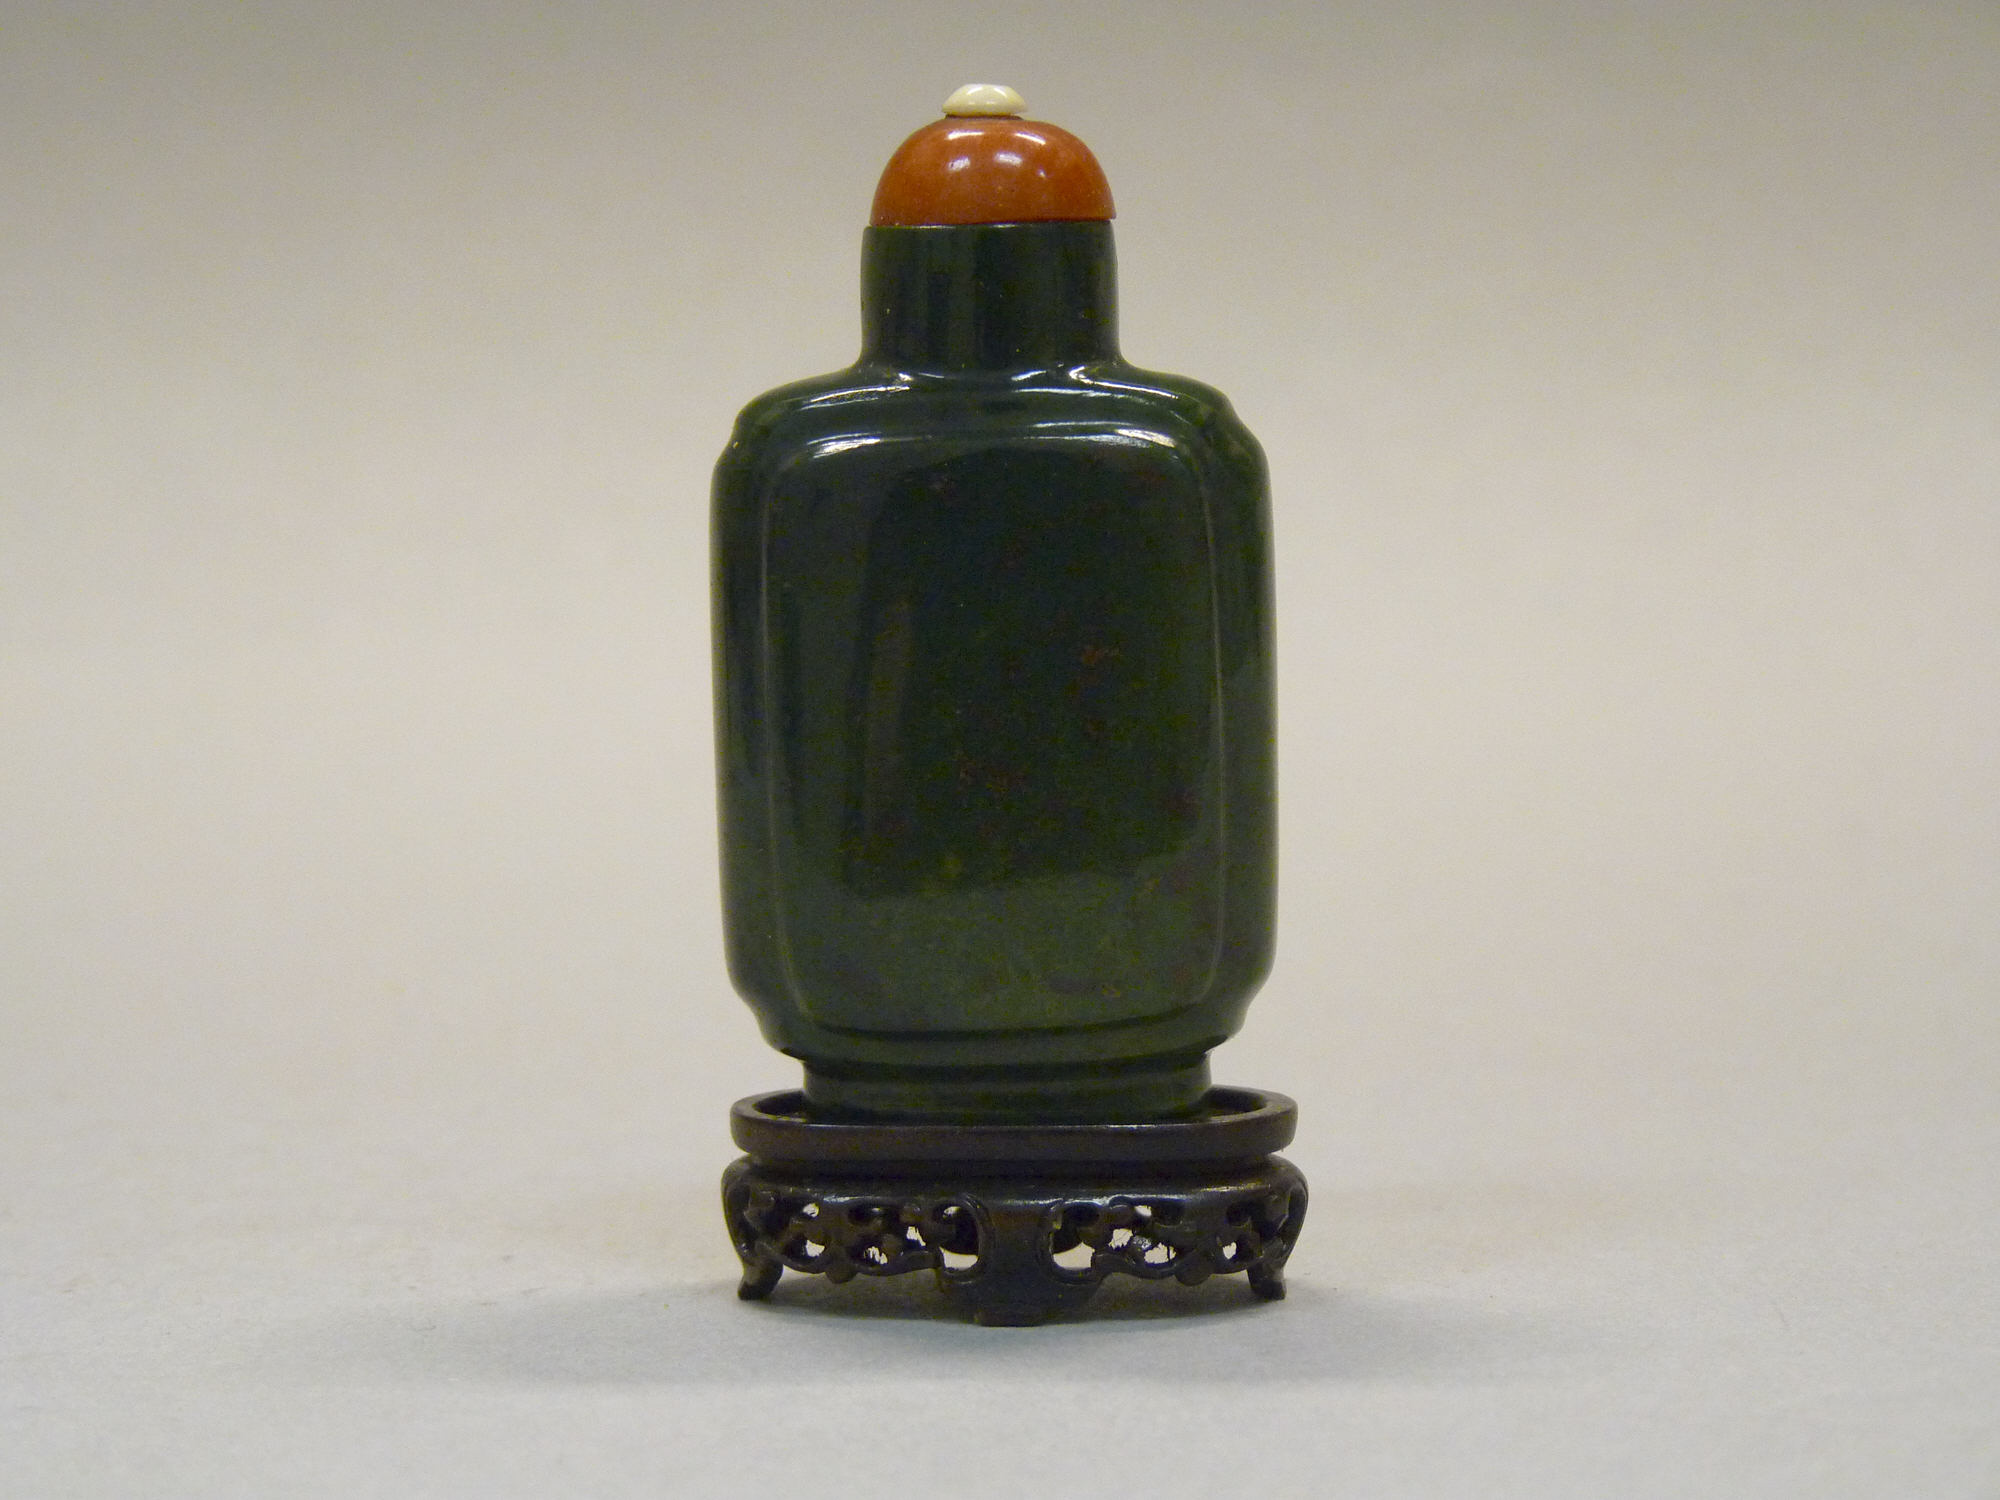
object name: snuff bottle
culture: chinese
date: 1801-1900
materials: stone